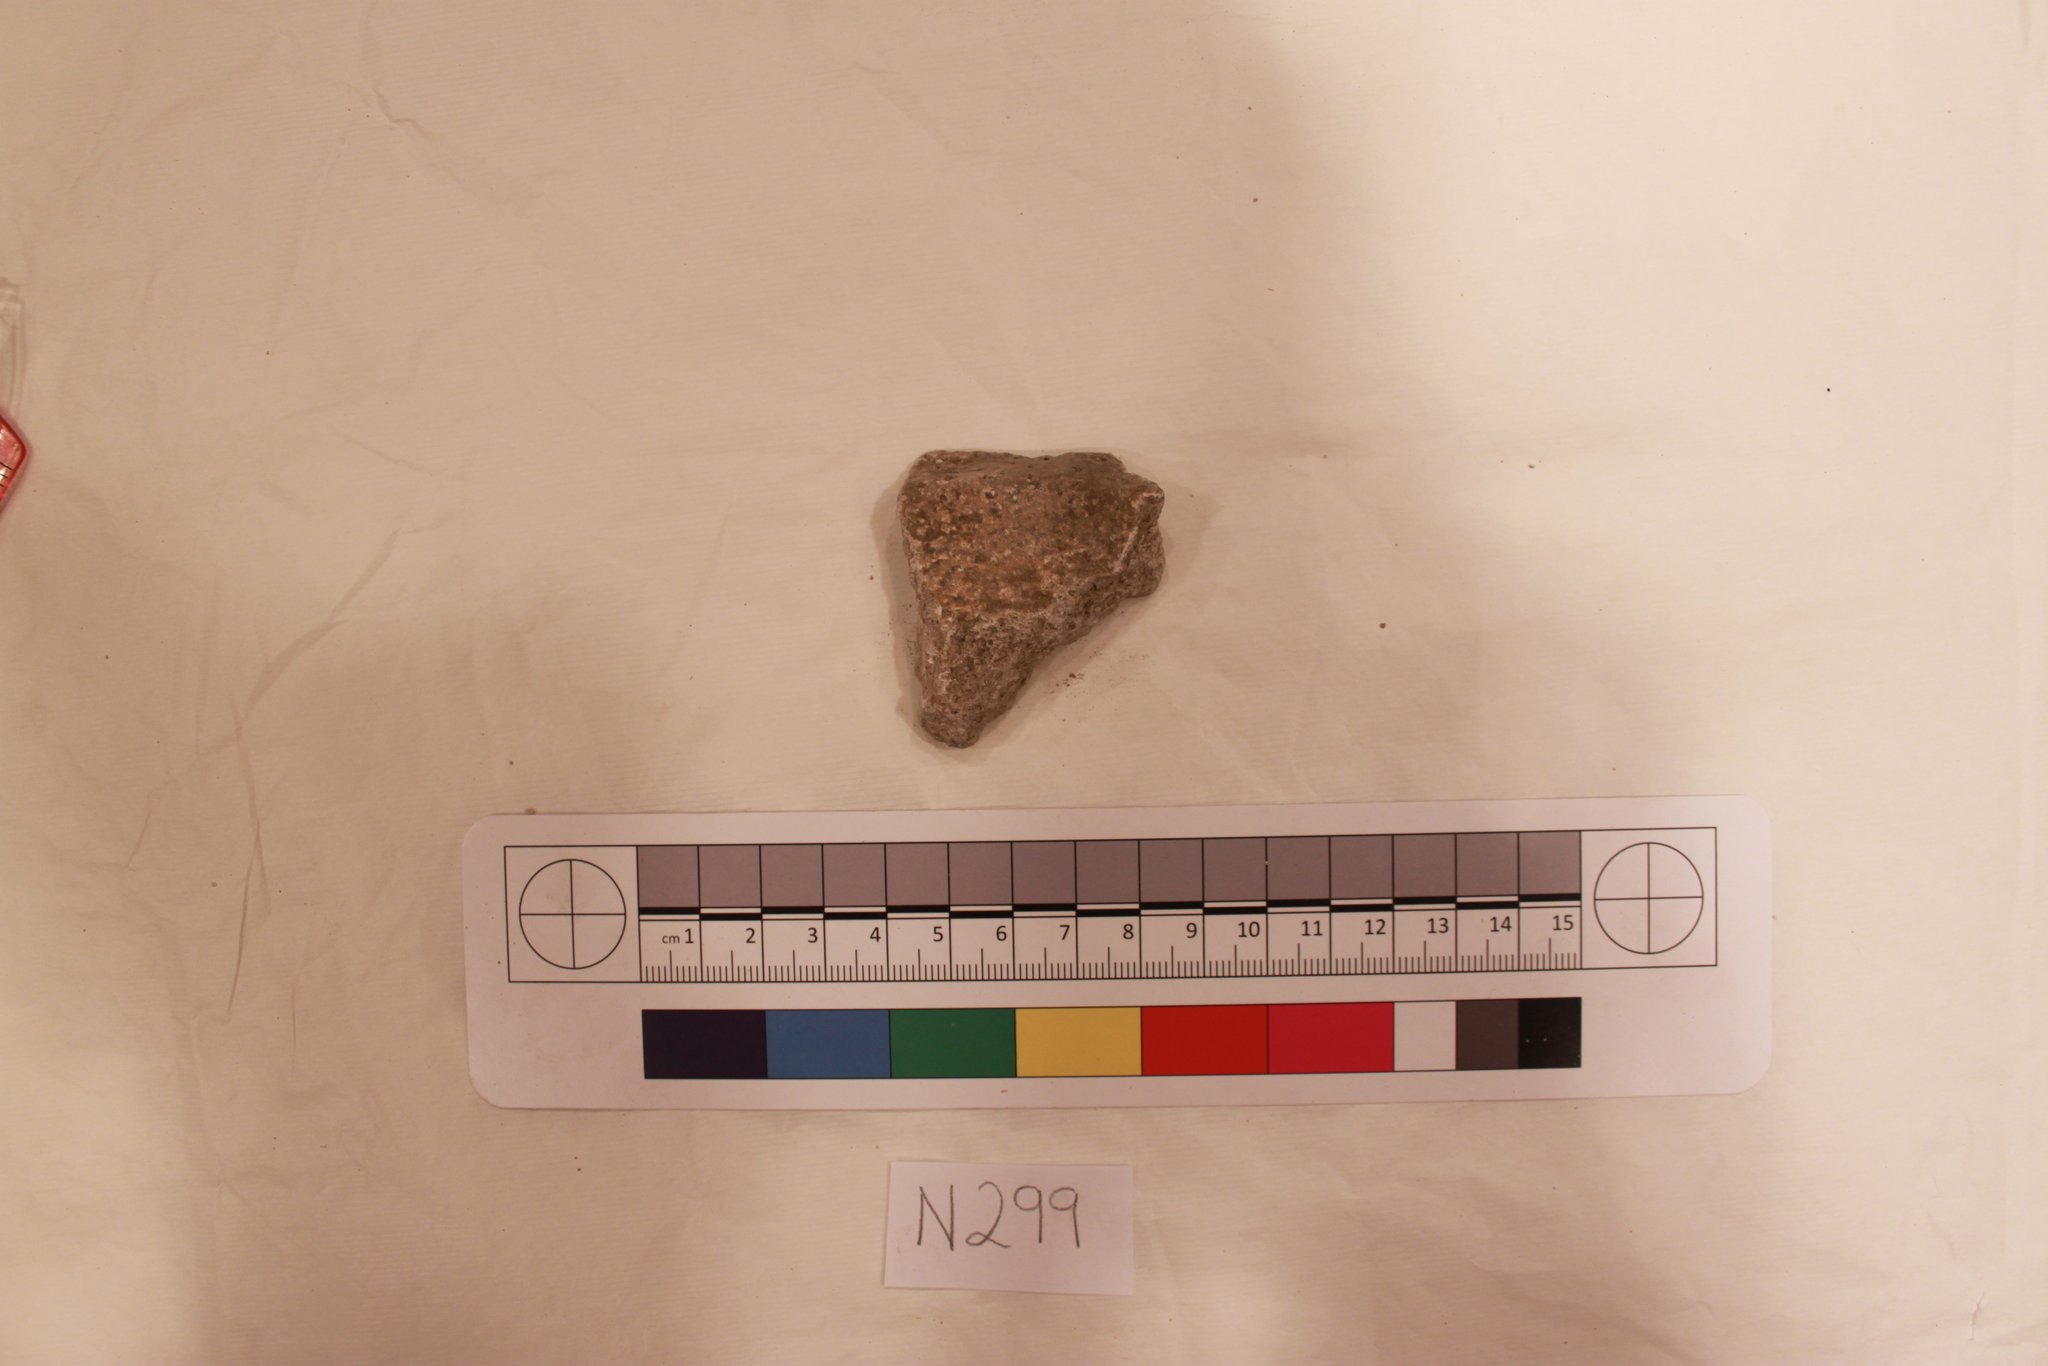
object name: fragment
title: Stucco Fragment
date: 701-1200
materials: plaster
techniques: carving, painting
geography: iran